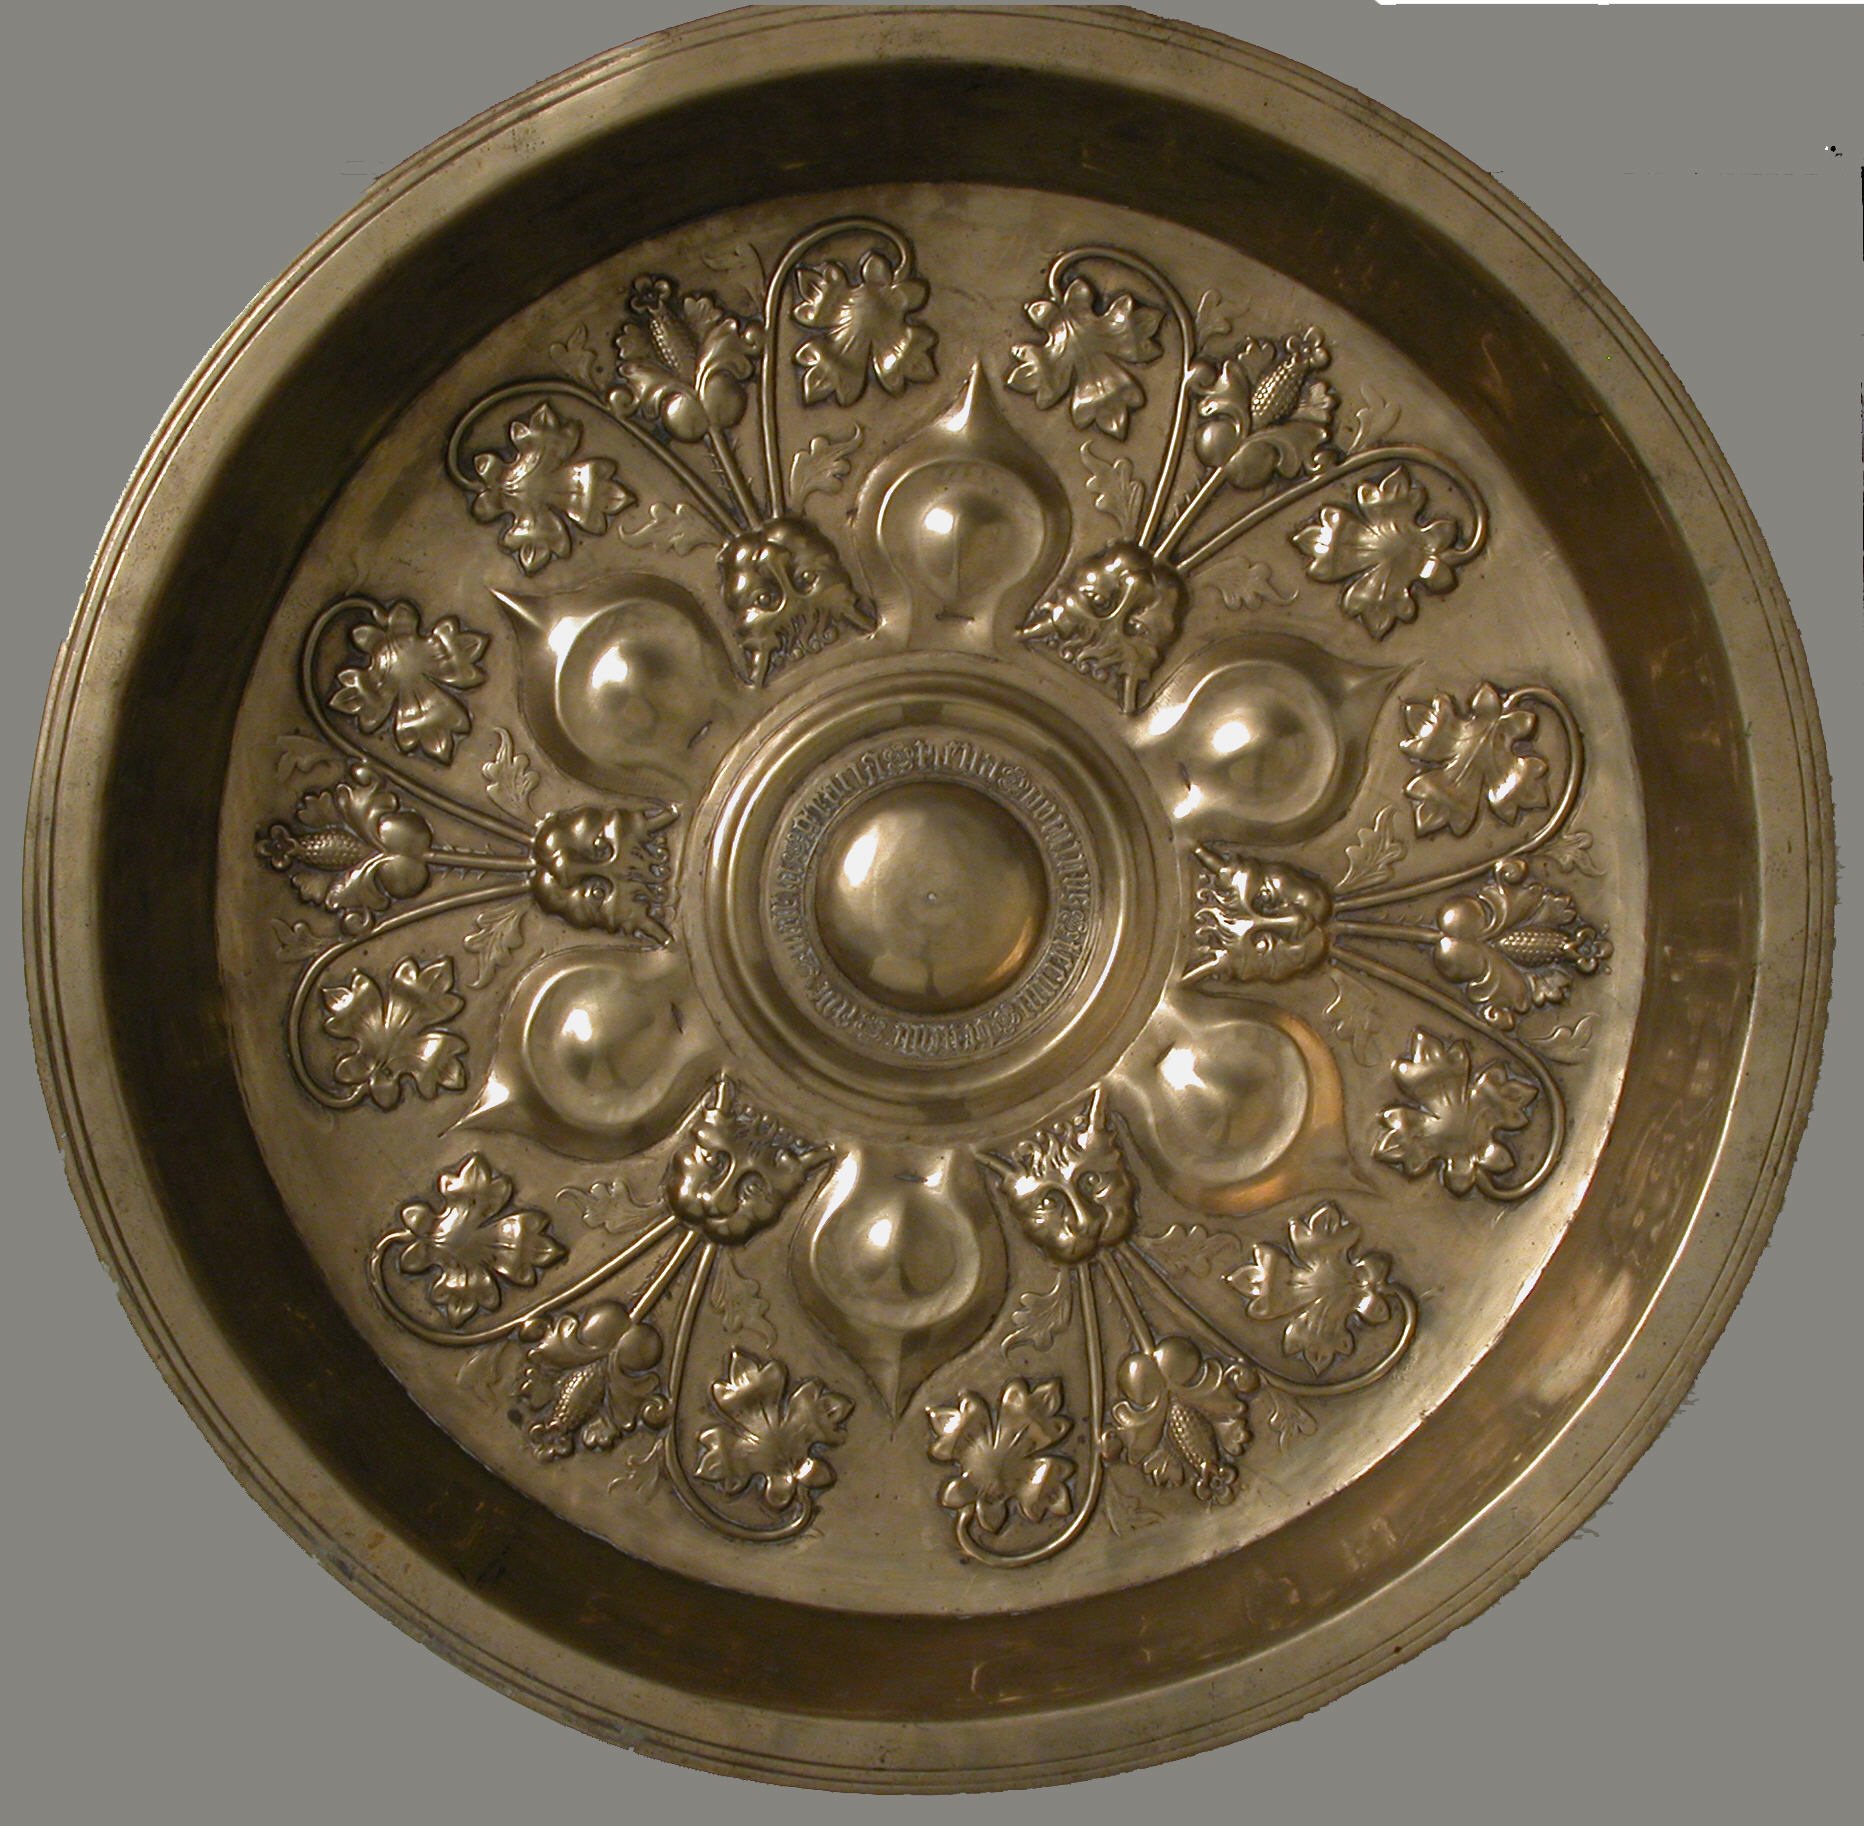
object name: plate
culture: german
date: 1475-1500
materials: brass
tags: flowers